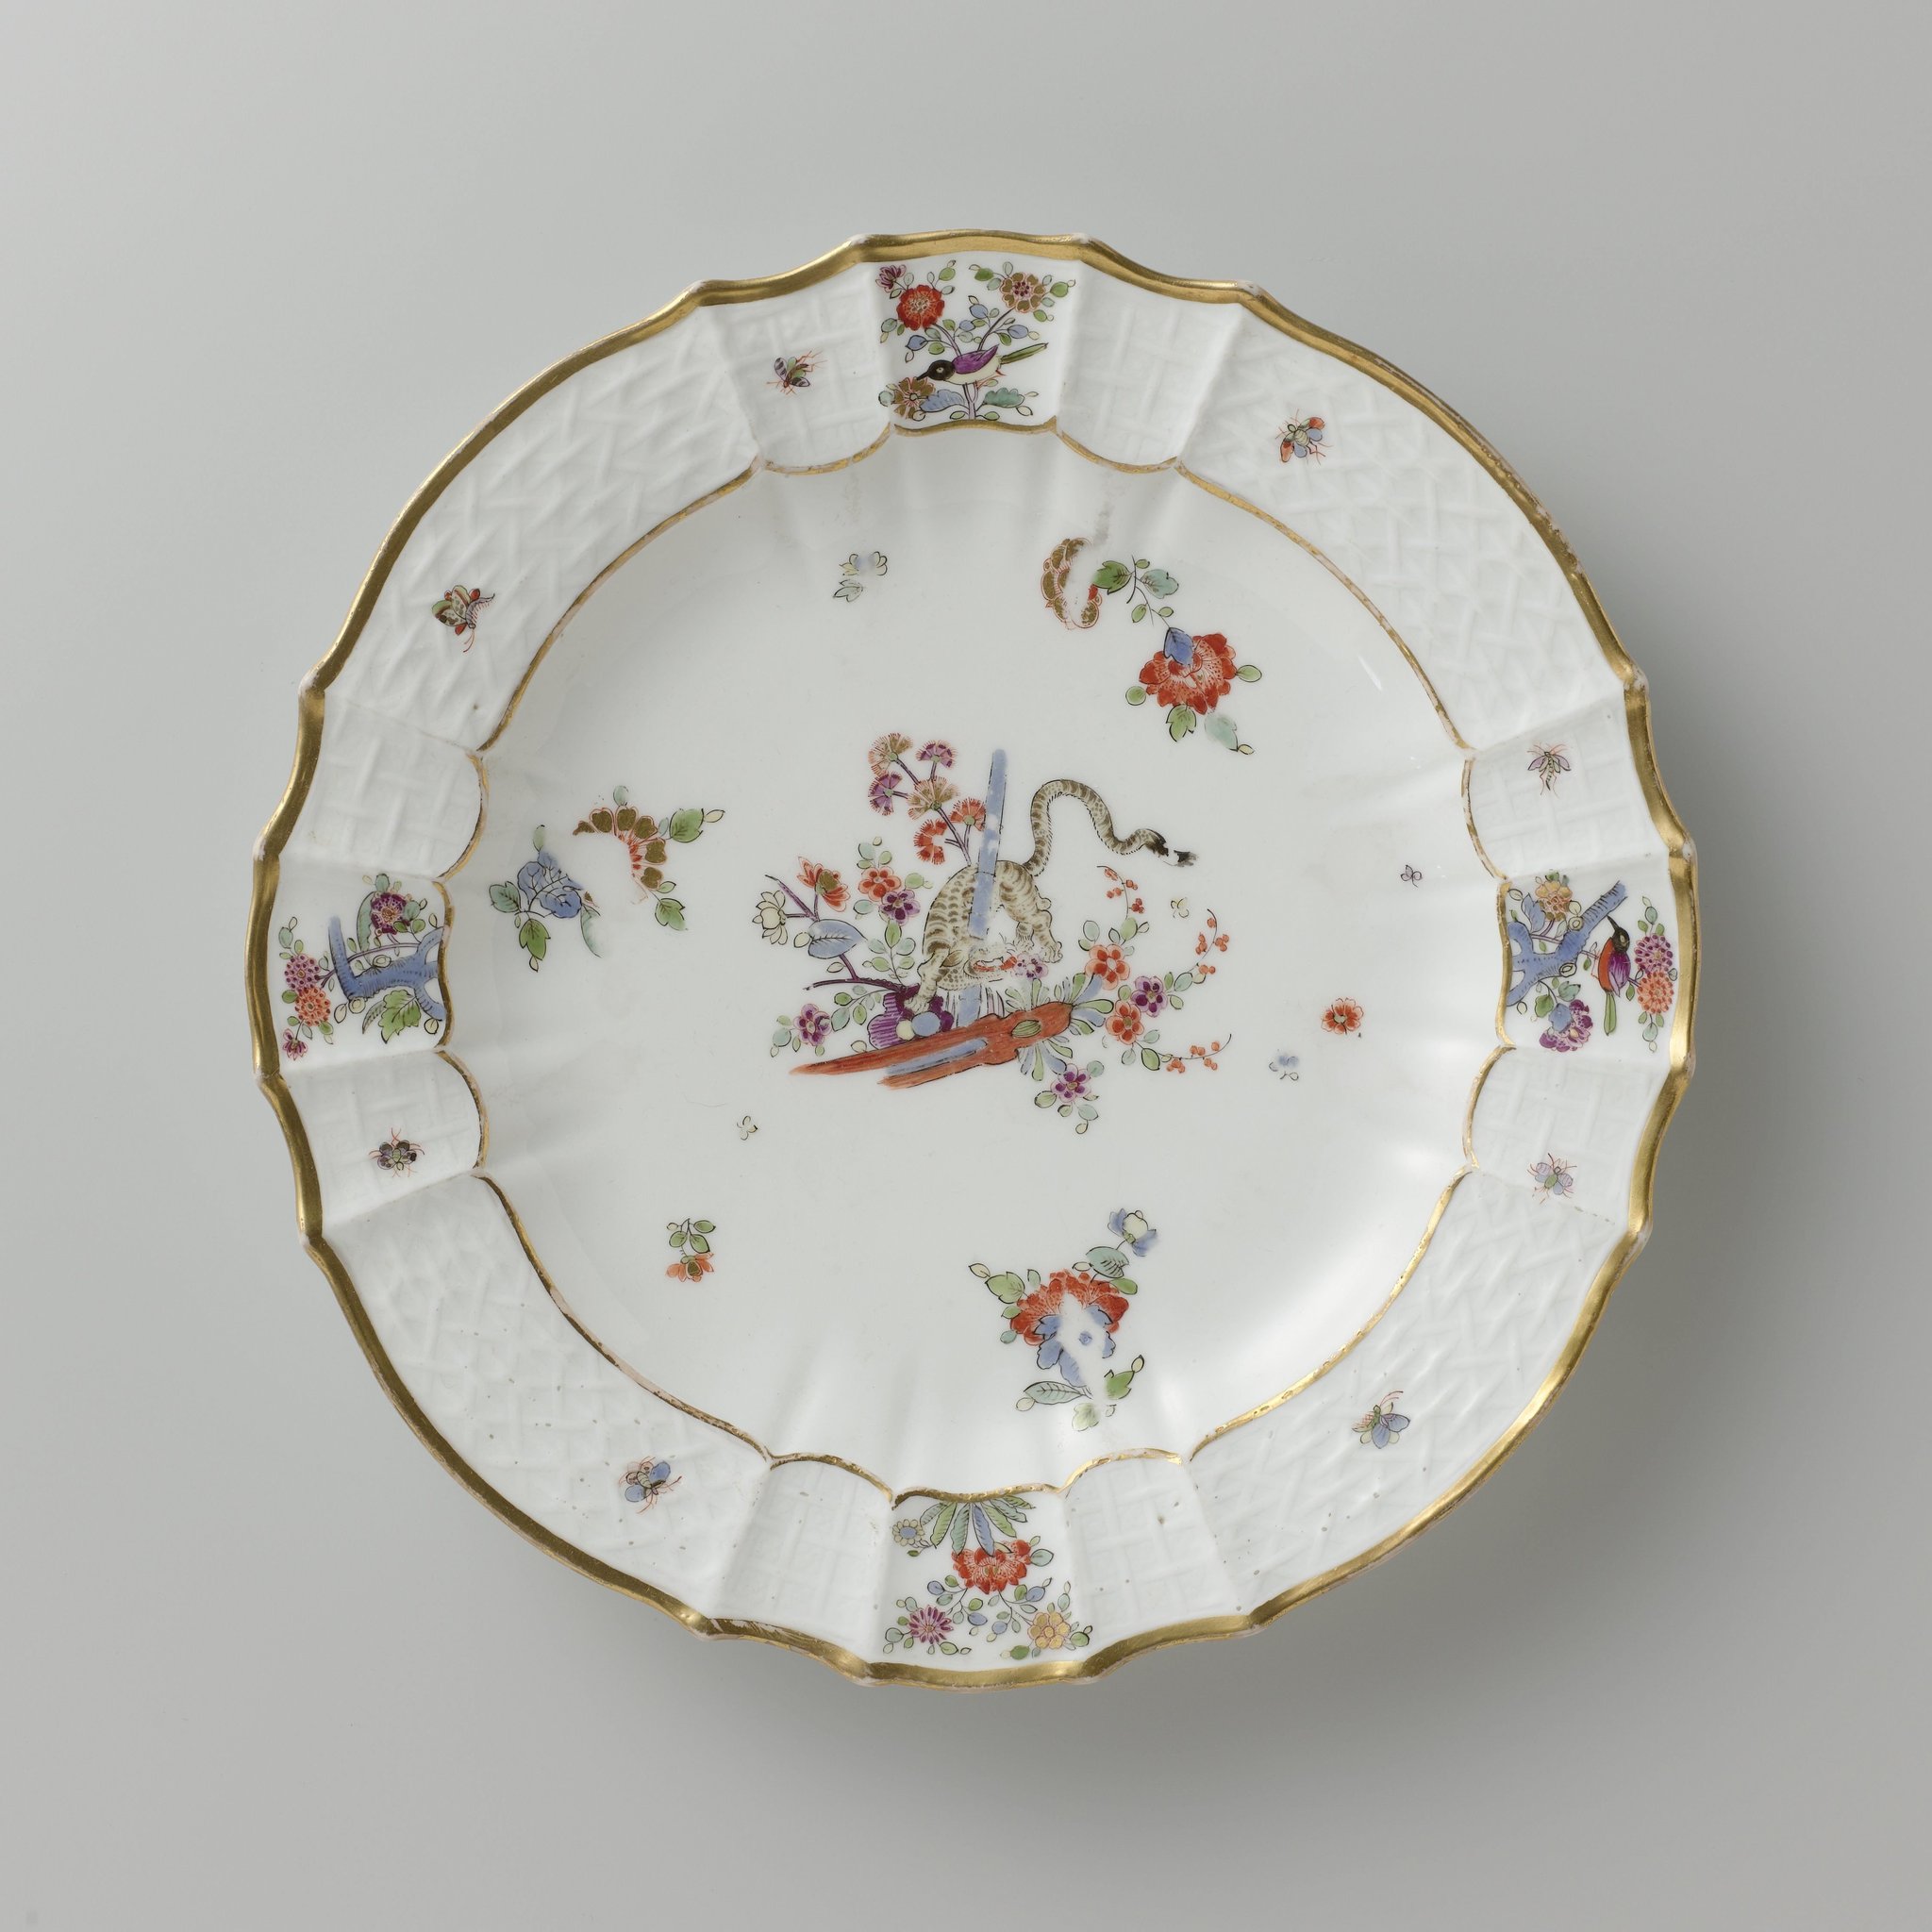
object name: eating drinking utensil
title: Rond bord, veelkleurig beschilderd met een Kakiemon-decor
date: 1740-1745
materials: porcelain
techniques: painted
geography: meissen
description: Rond bord van beschilderd porselein. Het bord is geribd en heeft een geschulpte rand. Het bord is beschilderd met een tijger die om een blauwe bamboestengel tussen bloemen is gedraaid, gestrooide Indianische Blumen, vlinders en takken waarop vogels. De rand is versierd met het 'Altbrandenstein'-patroon. Het bord is gemerkt.